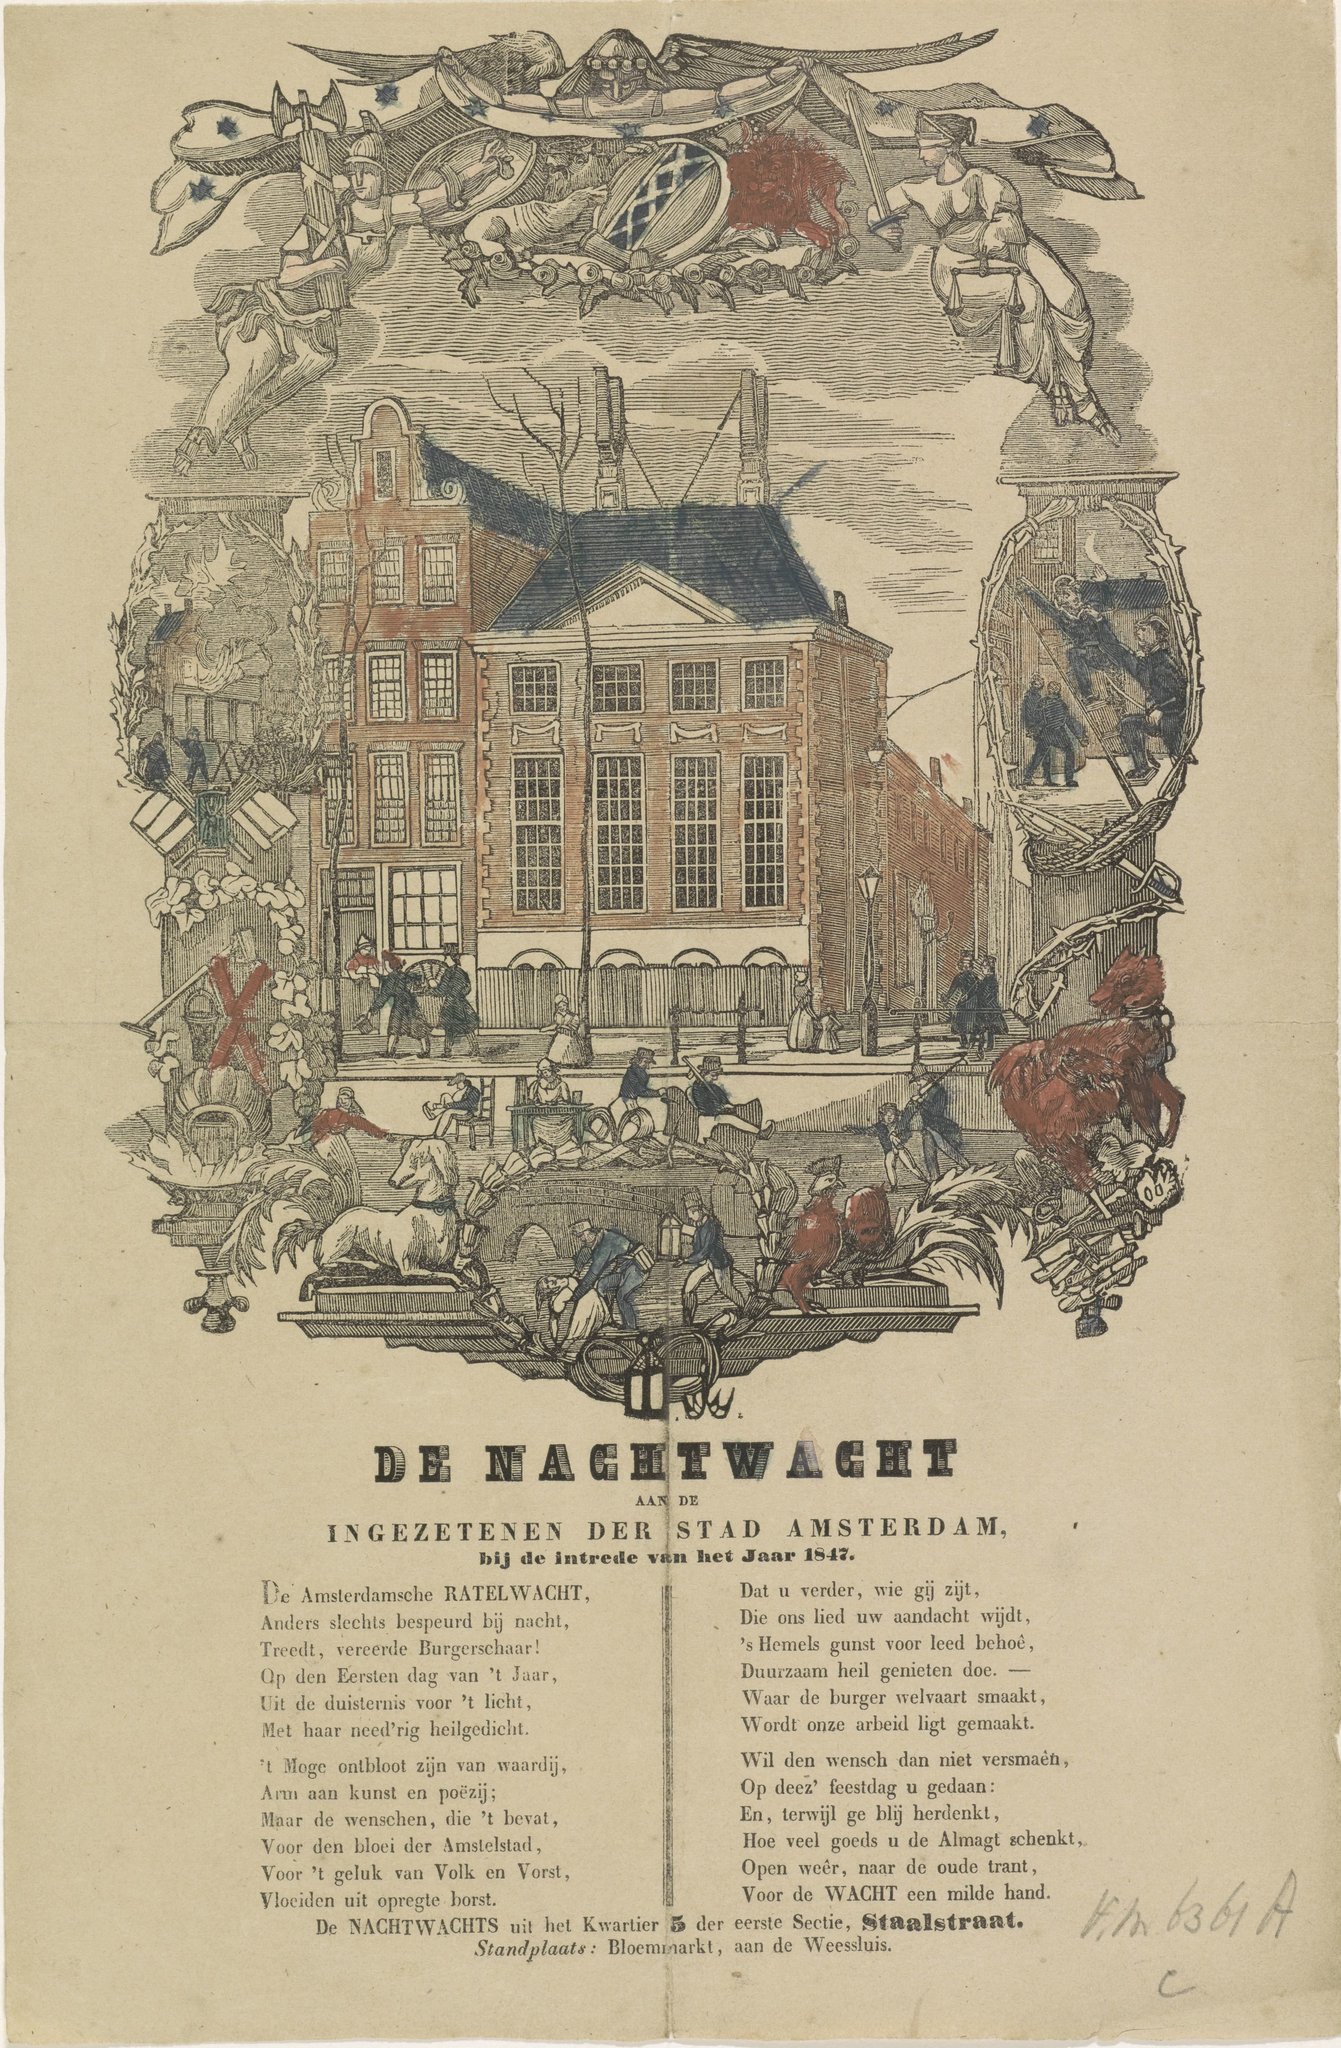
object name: new year card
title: Nieuwjaarswens van de Amsterdamse nachtwacht voor het jaar 1847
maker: Anonymous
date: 1846-1847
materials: paper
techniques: hand coloring, letterpress printing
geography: netherlands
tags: night patrol, street, amsterdam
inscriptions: collector's mark: Lugt 2228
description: Nieuwjaarswens van de Amsterdamse nachtwacht (ratelwacht) voor het jaar 1847. Centraal het Politiebureau op de Oudezijds Achterburgwal 183-185 met de Spinhuissteeg. Met schaatsers op het ijs. Binnen een kader met kleine voorstellingen van het werk van de nachtwacht. Met een vers in twee kolommen. Namens de nachtwacht in kwartier No. 5 van de 1ste Sectie, Staalstraat.